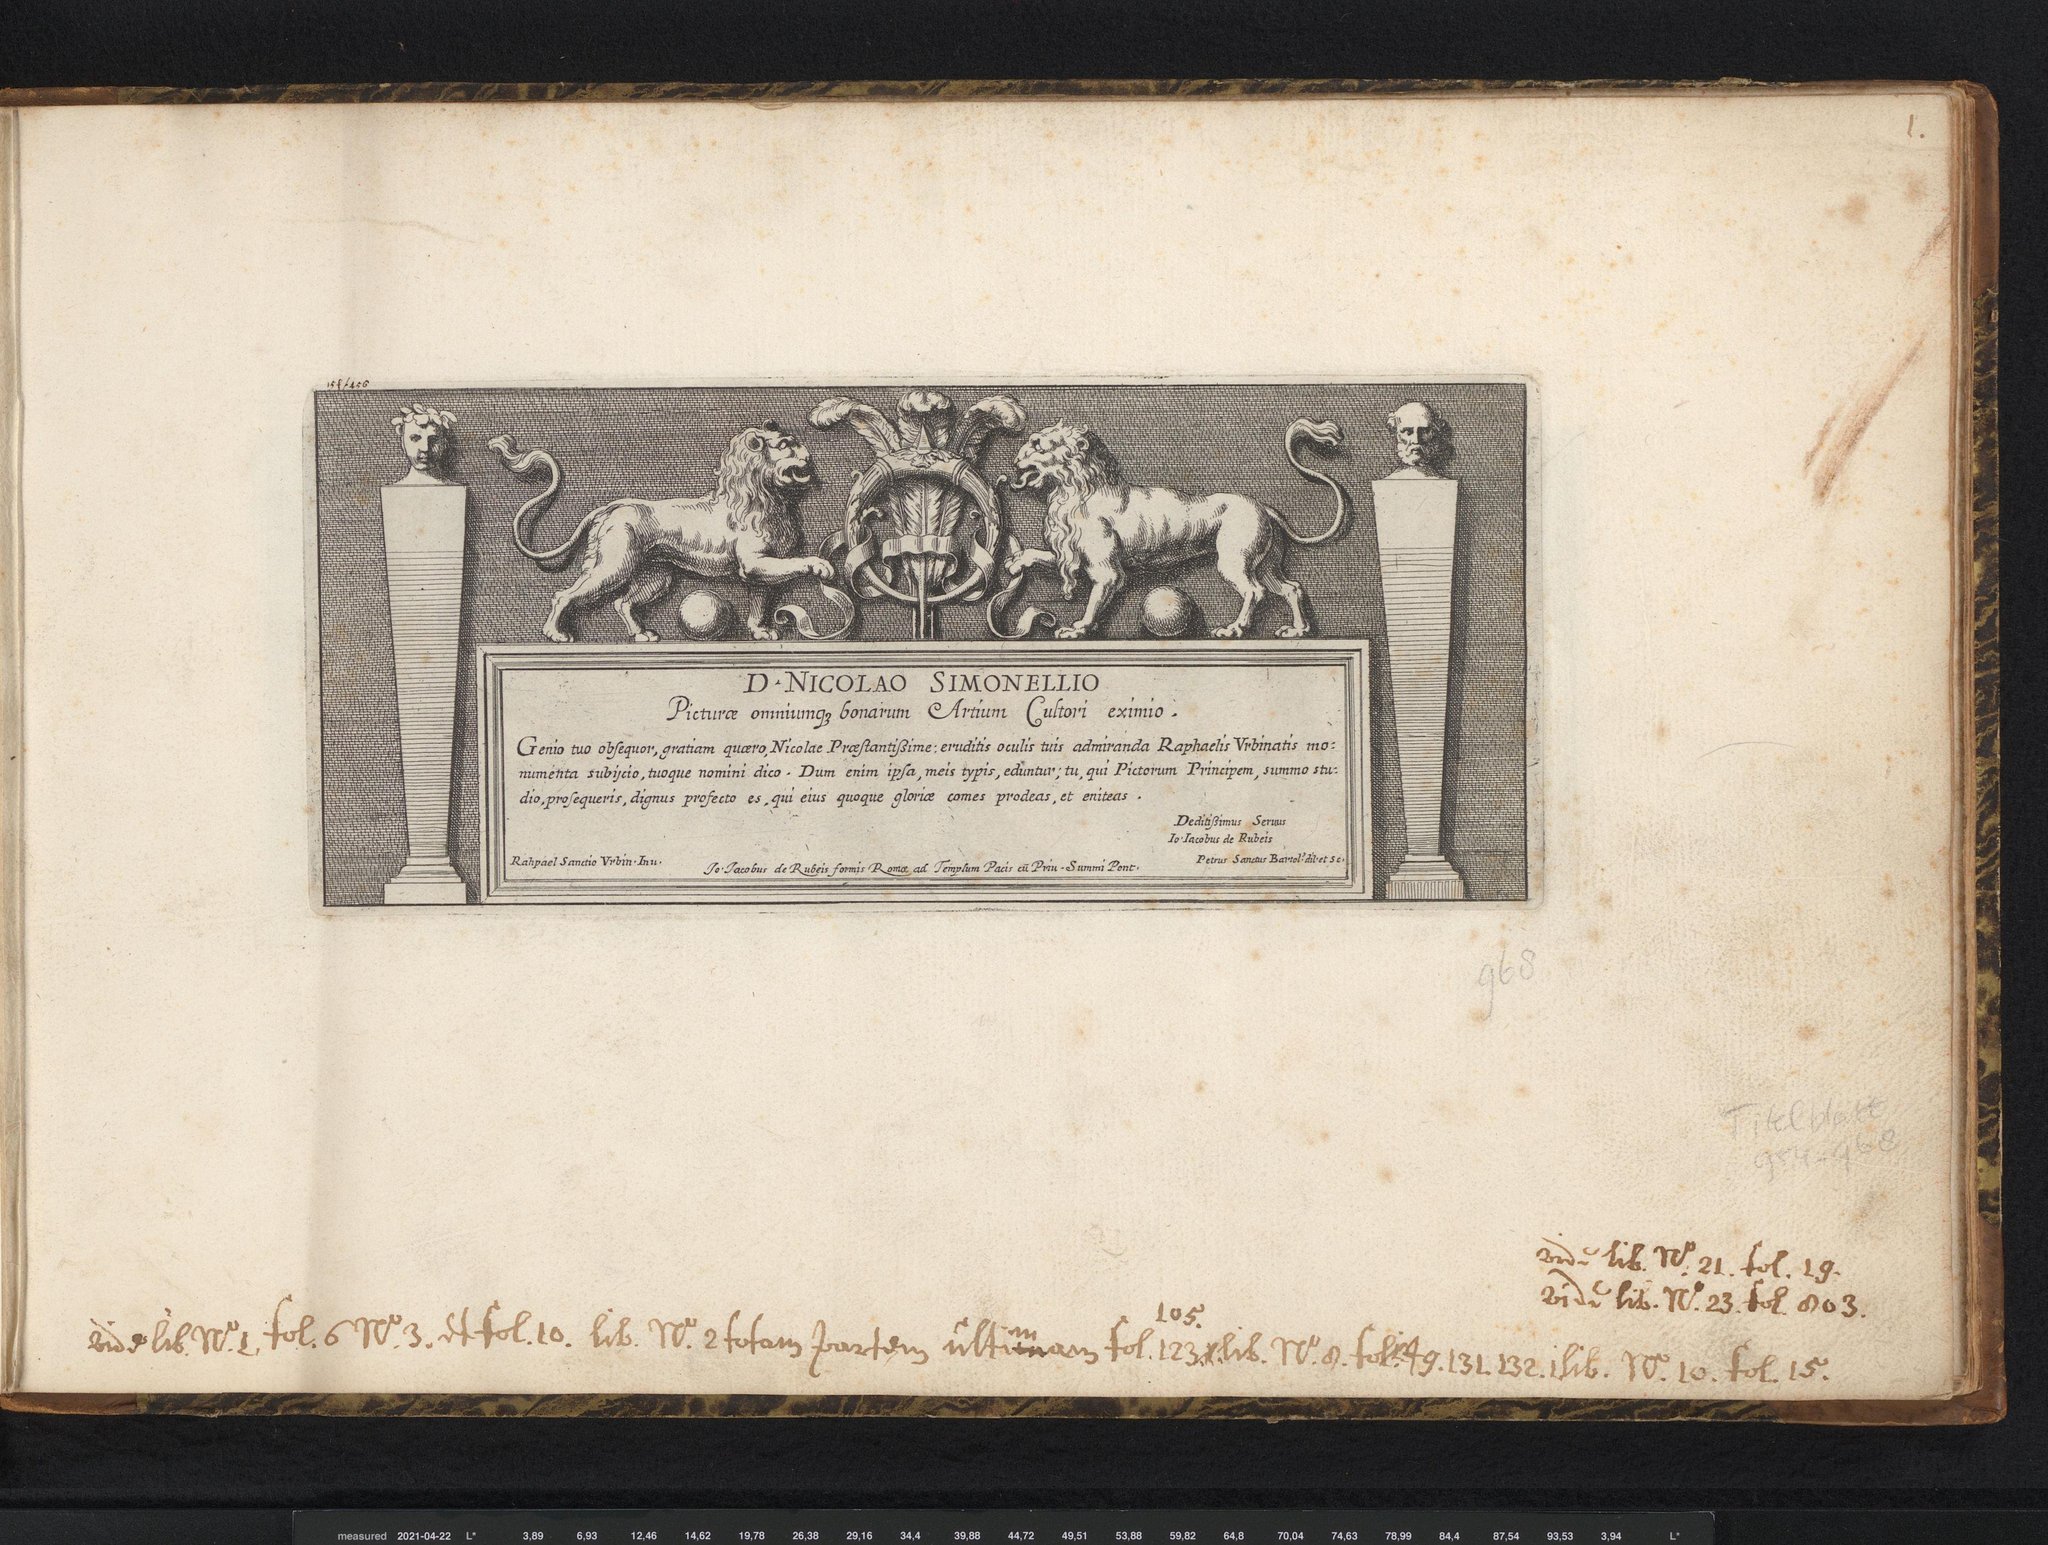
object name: album leaf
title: Titelprent met leeuwen en hermen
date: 1645-1700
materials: paper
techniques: engraving, etching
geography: italy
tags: herms (garden ornaments), beasts of prey, predatory animals: lion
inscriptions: number: ‘1’, inscription: ‘Ende lib. No. 1. fol. 6 No. 3. et fol. 10...’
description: Titelprent bij een reeks van 14 prenten naar schilderingen door Rafaël in de Stanze di Raffaello in het Apostolisch Paleis in het Vaticaan en naar ontwerpen voor wandtapijten voor de Sixtijnse Kapel door Rafaël.